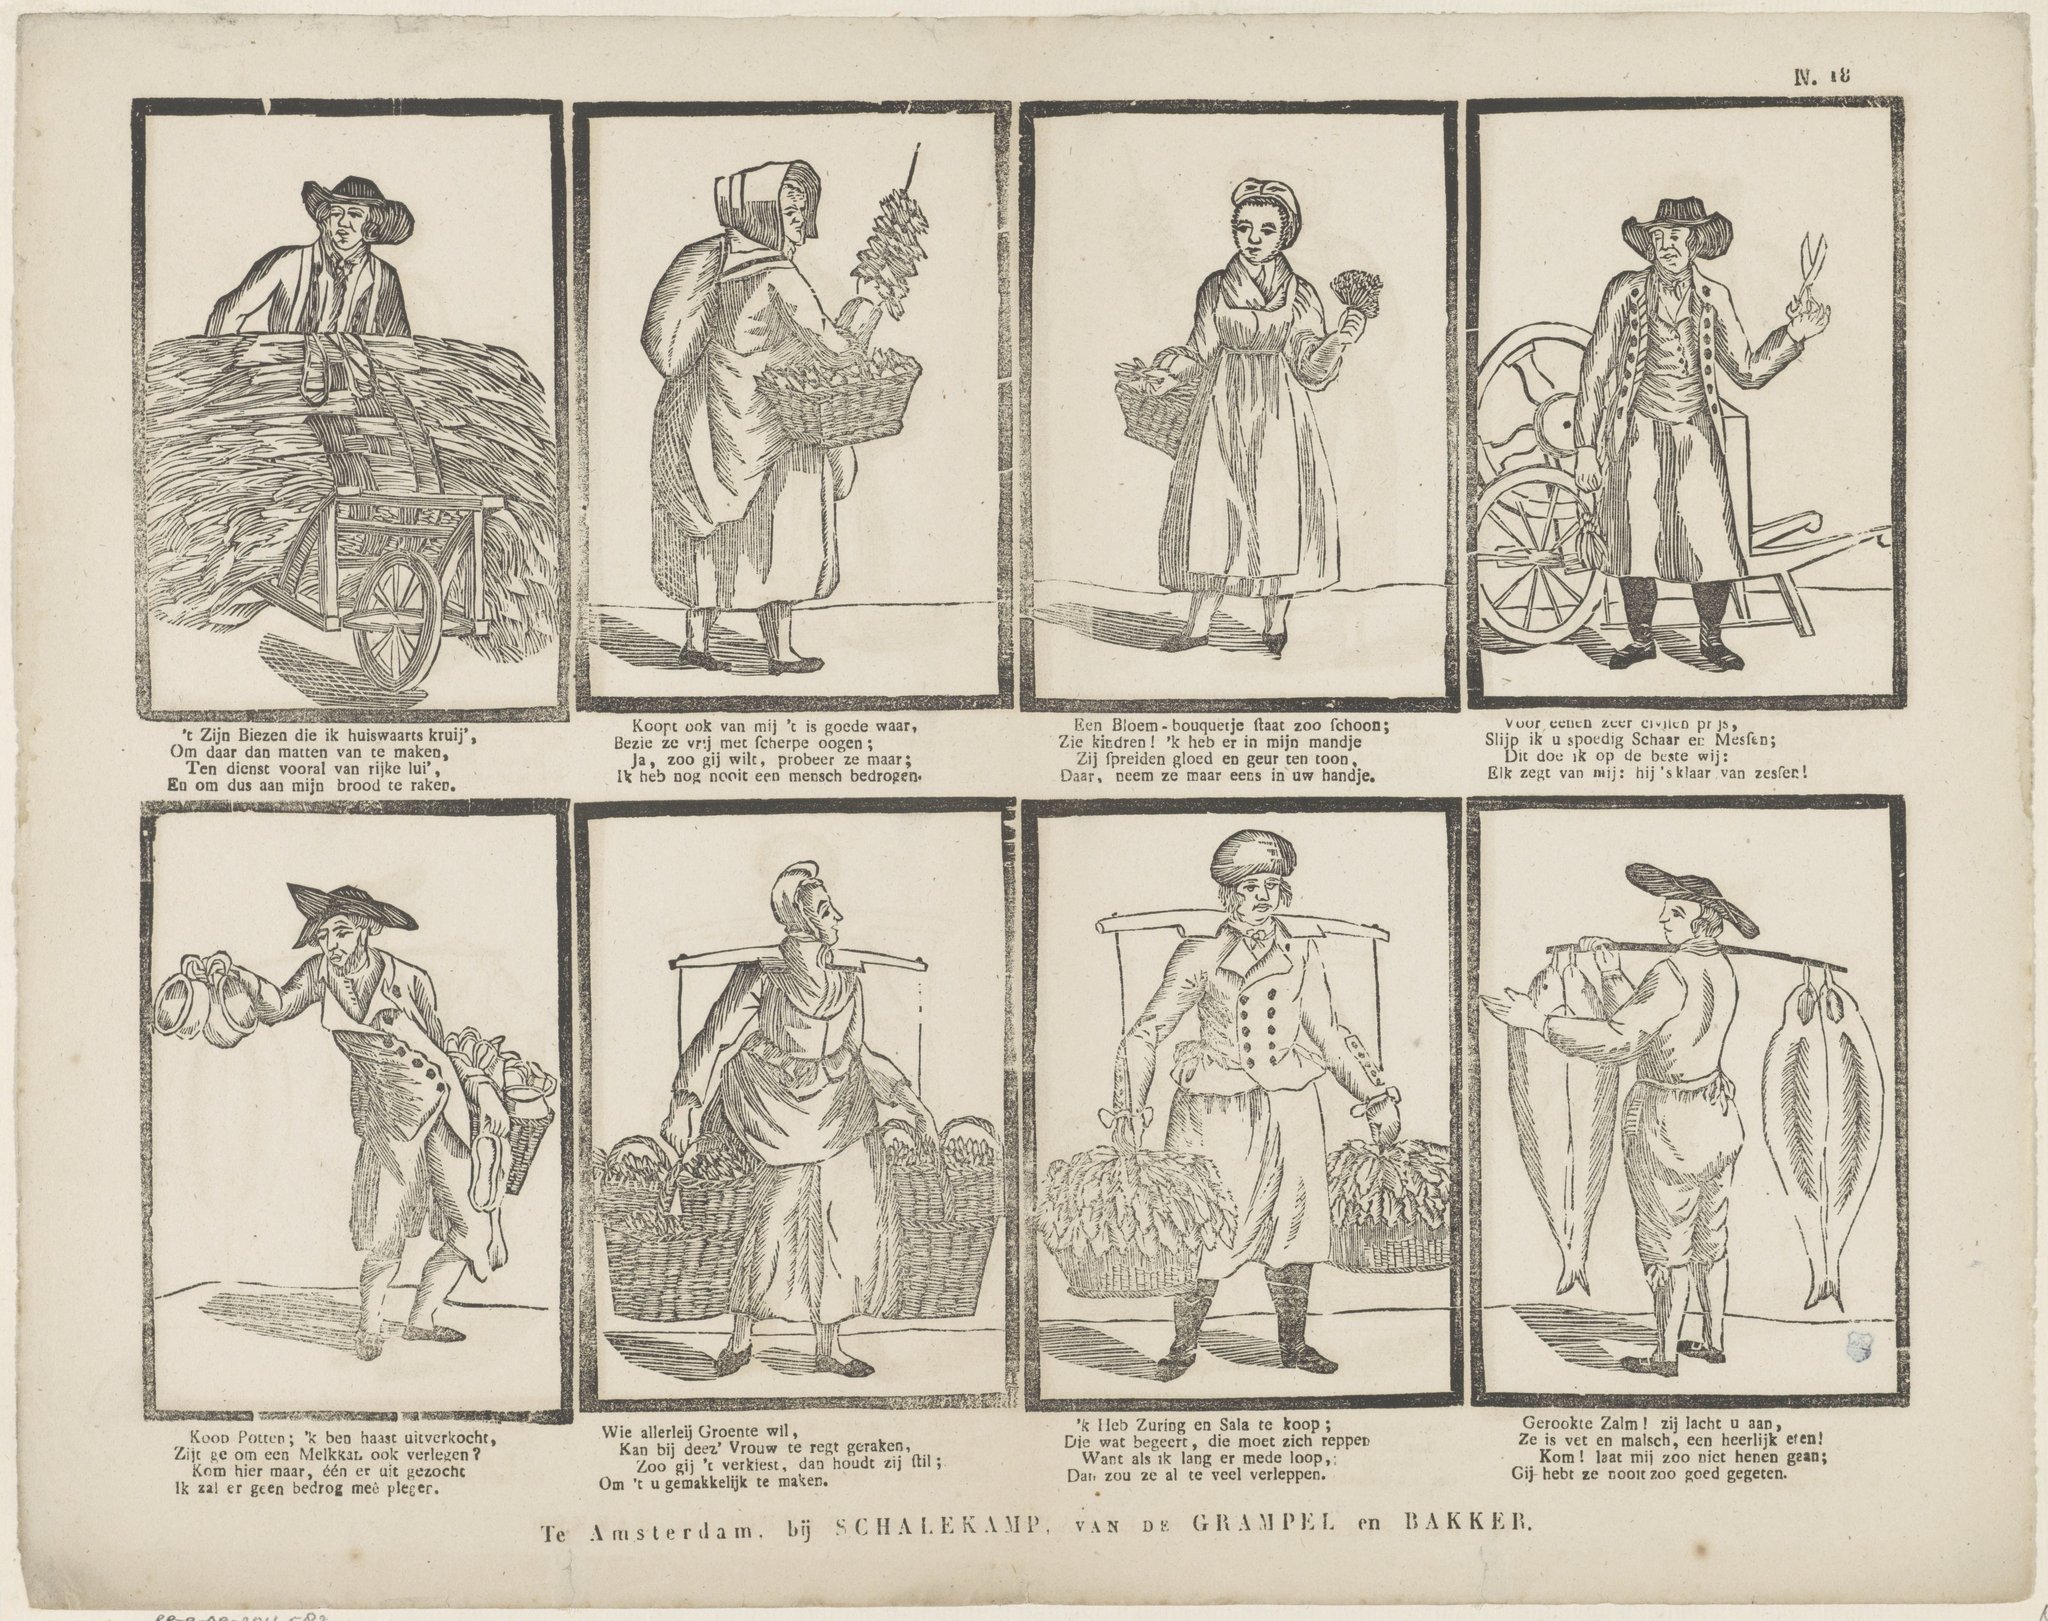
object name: popular print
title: Straatverkopers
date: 1822-1849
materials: paper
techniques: letterpress printing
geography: netherlands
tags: street-trader, merchant, salesman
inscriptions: collector's mark: Lugt 2760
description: Blad met 8 voorstellingen van straatverkopers, zoals een mattenverkoper, een pottenverkoper en een zalmverkoper. Onder elke afbeelding een vierregelig vers. Genummerd rechtsboven: N. 18.